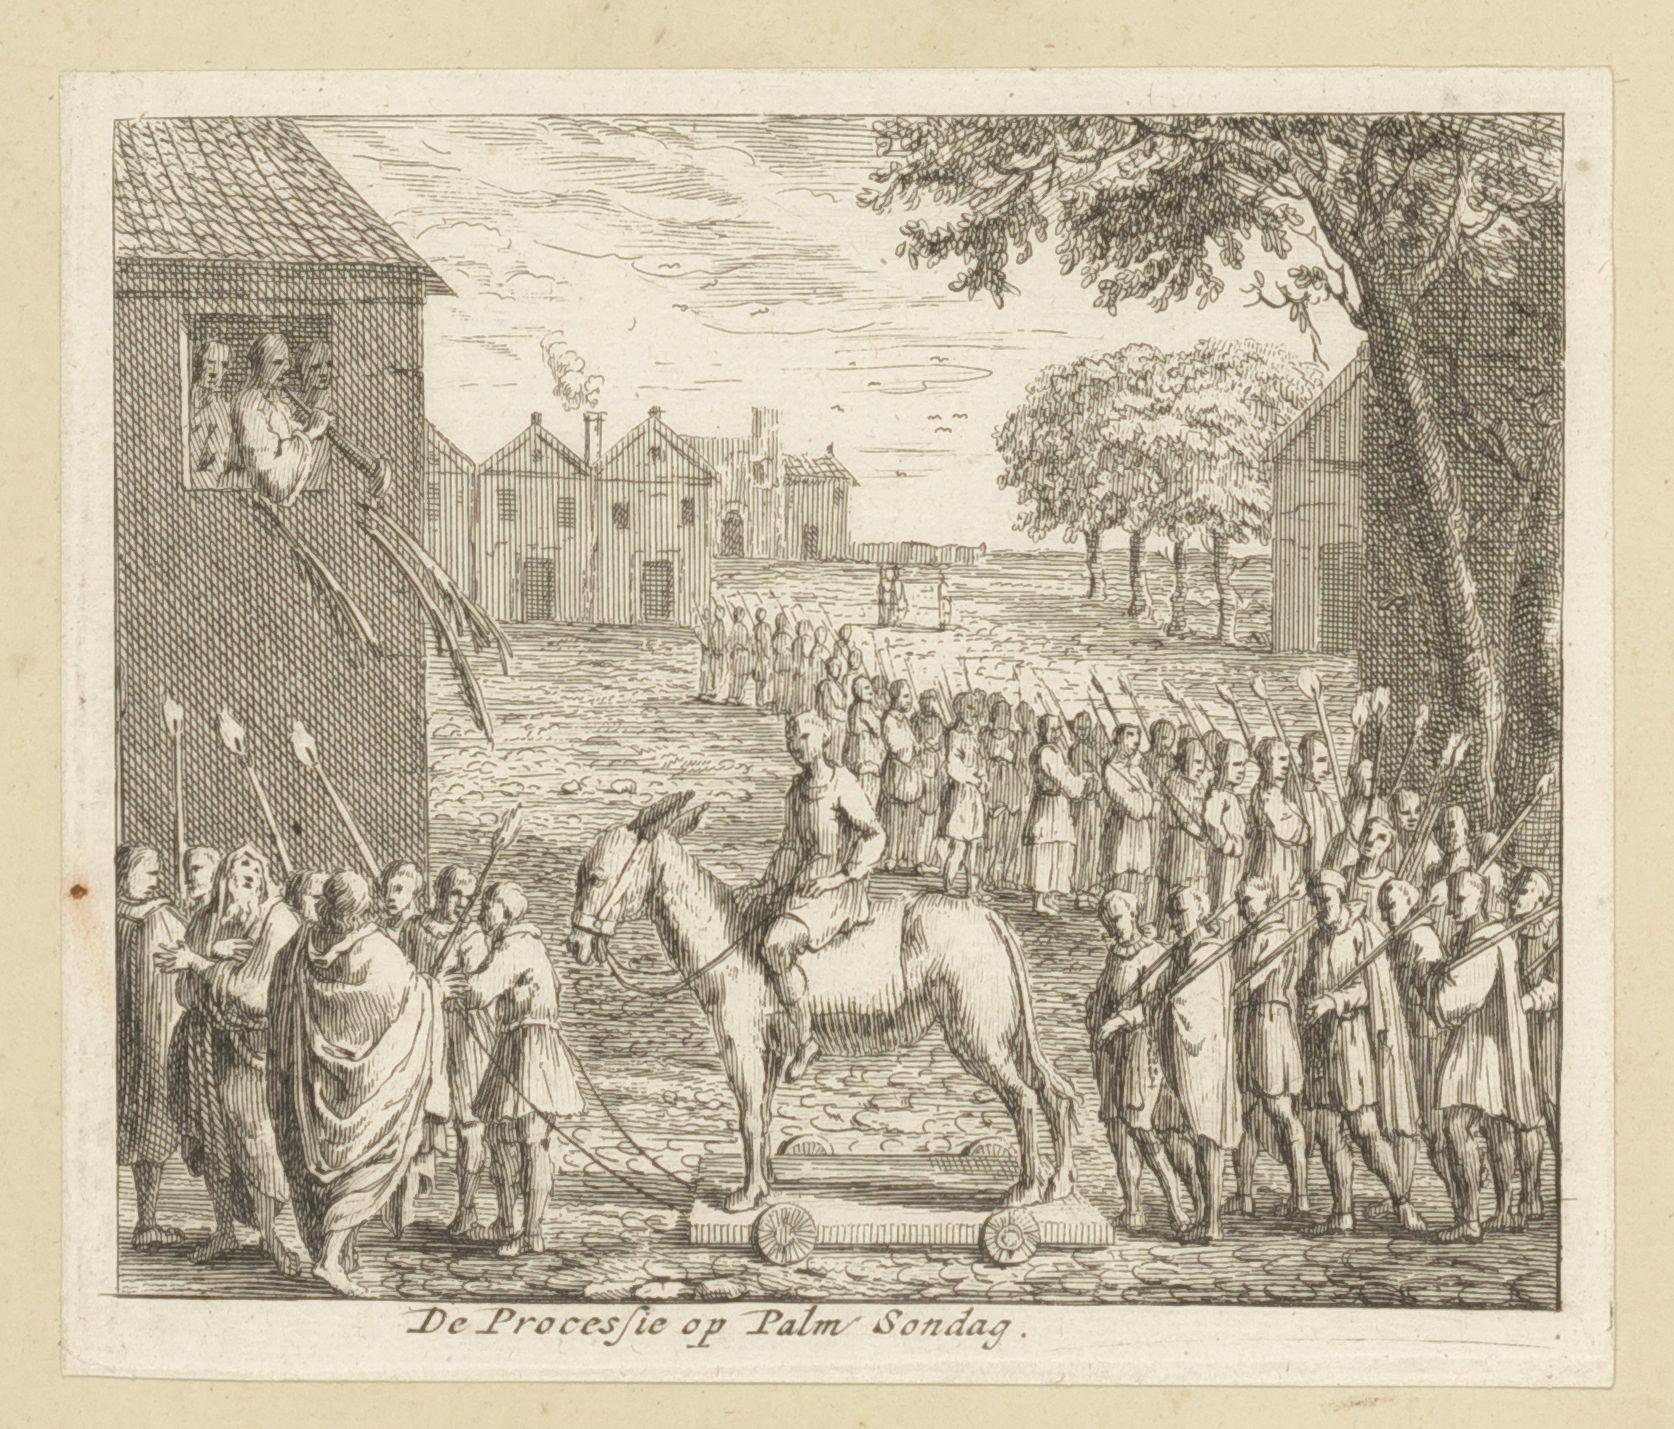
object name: print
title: Processie op Palmzondag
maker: Anonymous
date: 1727-1729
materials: paper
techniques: engraving, etching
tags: palm sunday, ass, donkey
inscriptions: collector's mark: Lugt 1641, stamp, stamp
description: Prent waarschijnlijk uit: Long, Isaac le. Historische beschrijvinge van de Reformatie der stadt Amsterdam (...). Amsterdam: Johannes van Septeren, 1729, tussen p. 490 en 491.